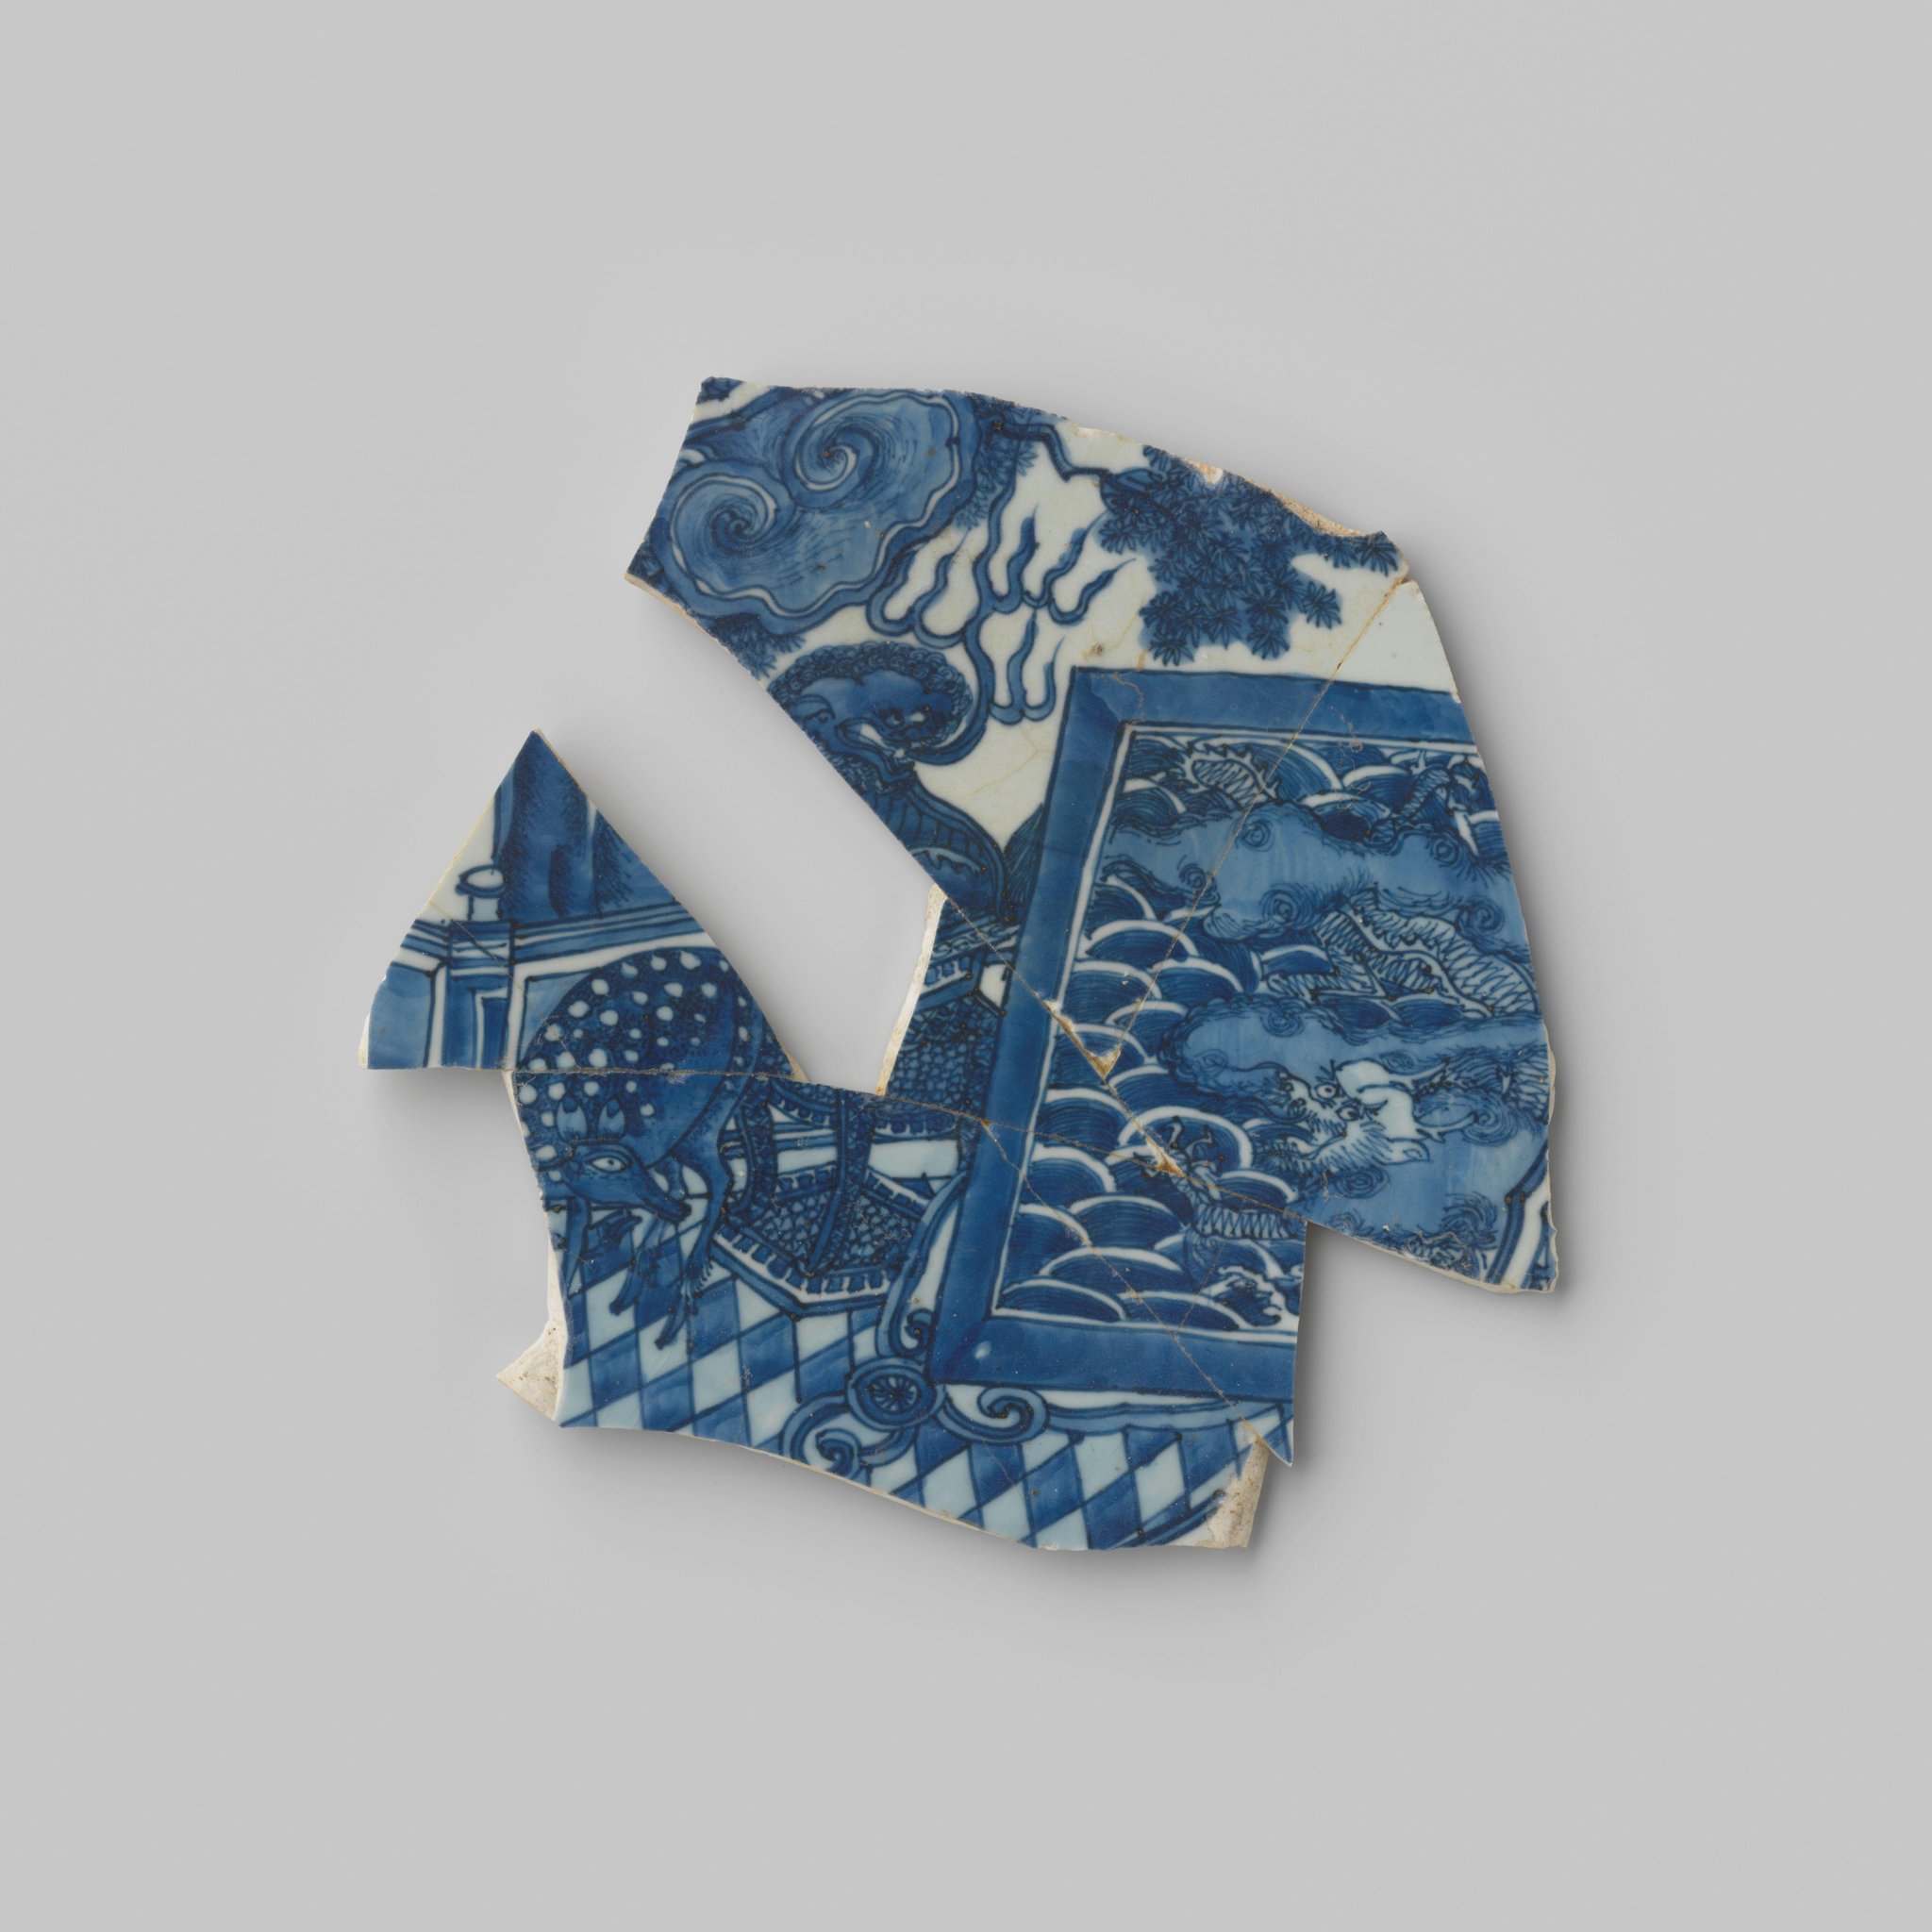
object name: washbowl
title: Fragment schotel uit V.O.C.-schip de 'Witte Leeuw'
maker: Anonymous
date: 1613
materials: bone china, glaze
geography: jingdezhen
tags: verenigde oostindische compagnie, sint-helena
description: A large plate with a flattened rim. A scalloped medallion with rui heads within concentric bands filled with alternating diaper patterns. A central decoration of a deer and a lion next to a screen which is decorated with a dragon in the waves, all standing on a terrace near a pinetree.